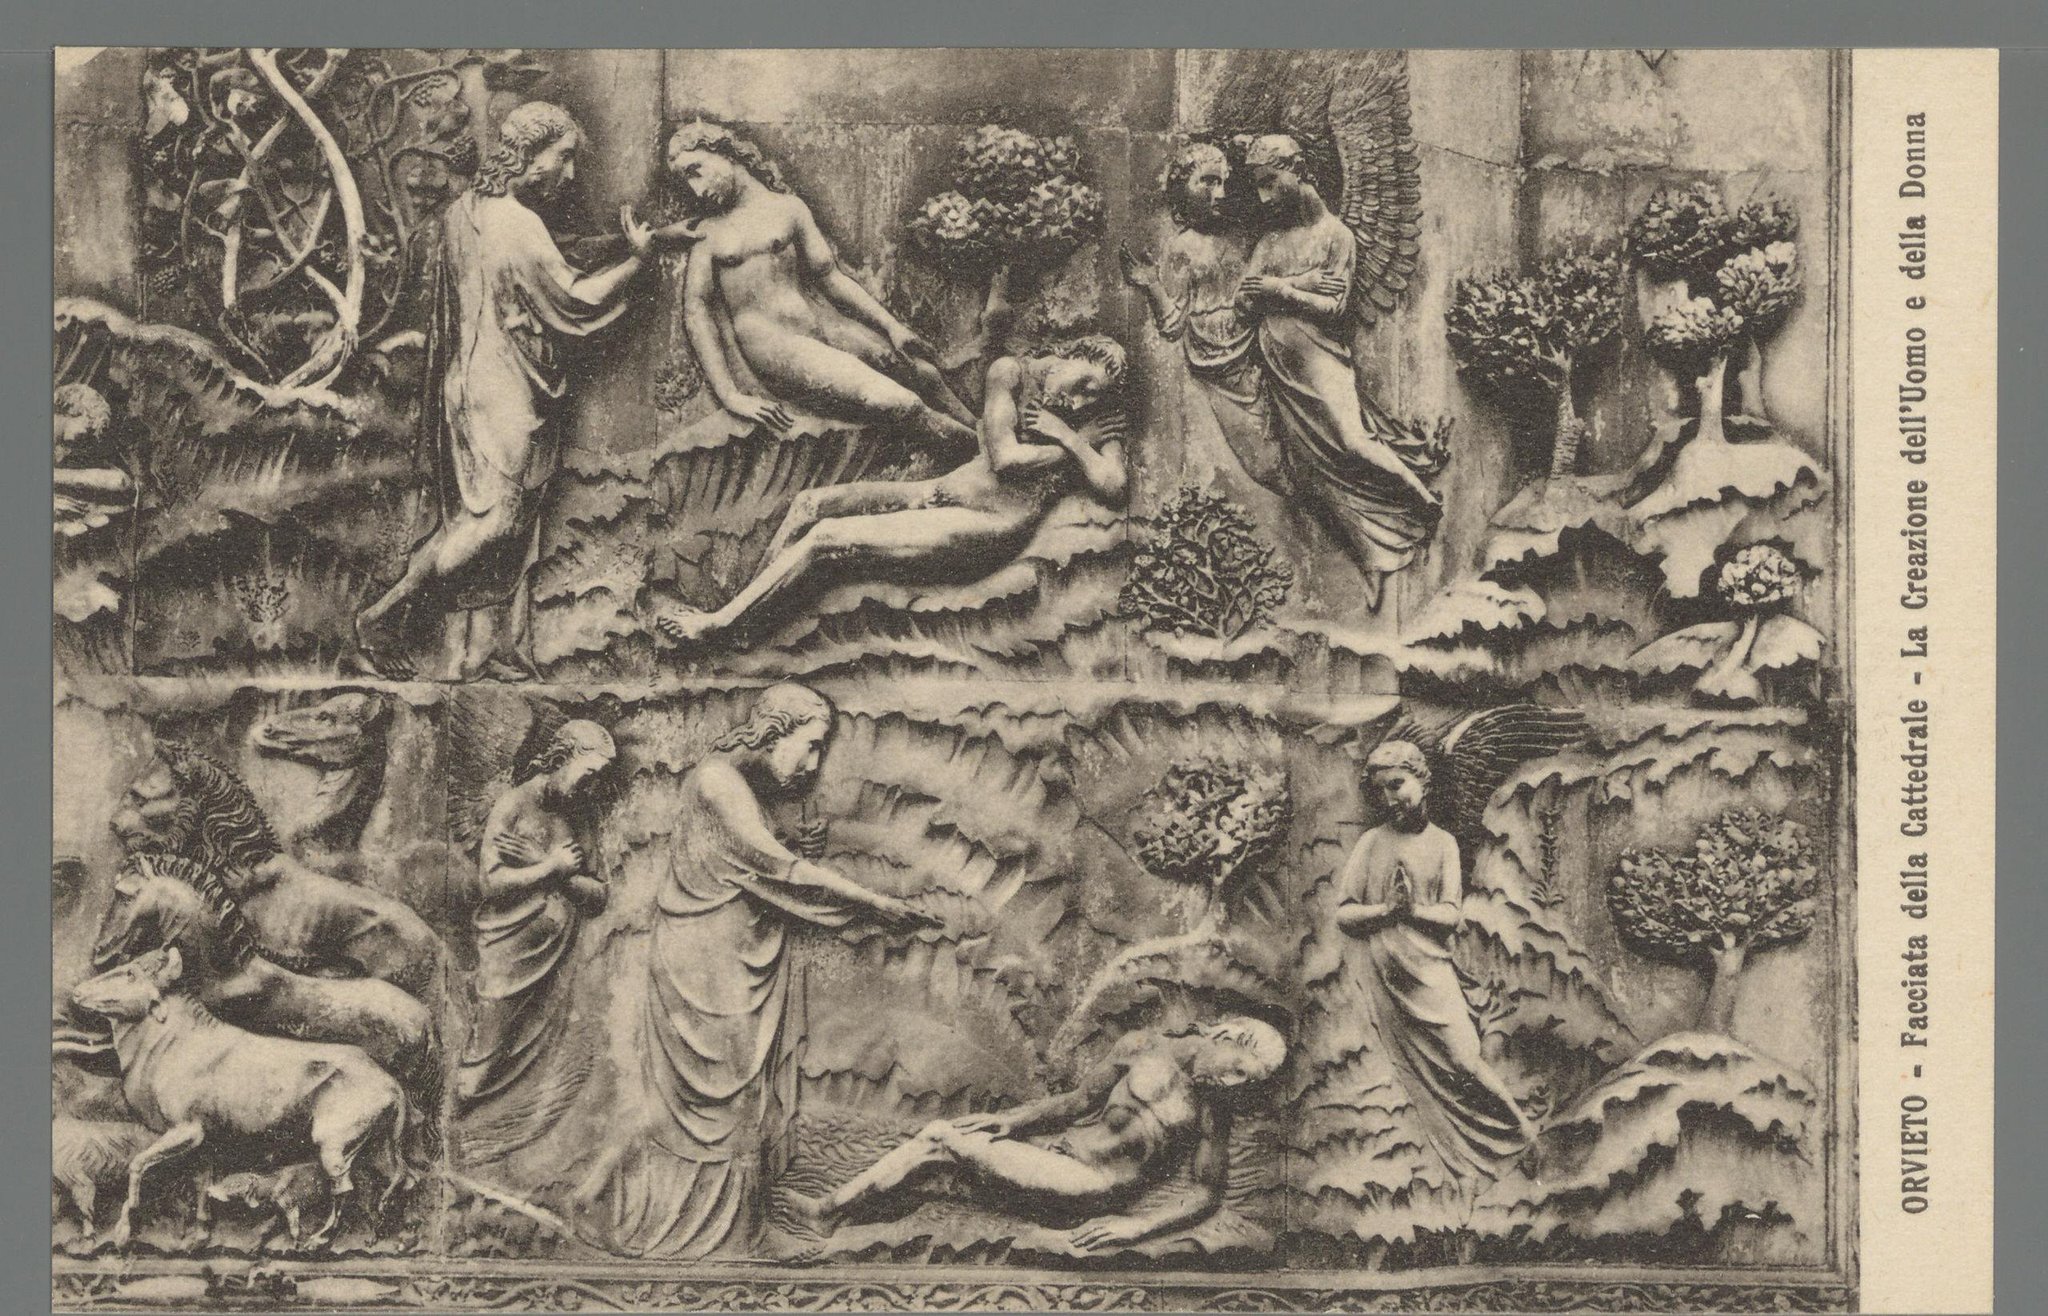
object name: ansichtkaart, prentbriefkaart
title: Orvieto. Facciata della Cattedrale. La Creazione dell'Uomo e della Donna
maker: Anonymous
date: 1910-1930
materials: cardboard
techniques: photograph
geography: terni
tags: church (exterior), sculpture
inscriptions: collector's mark: ‘AFE v S’